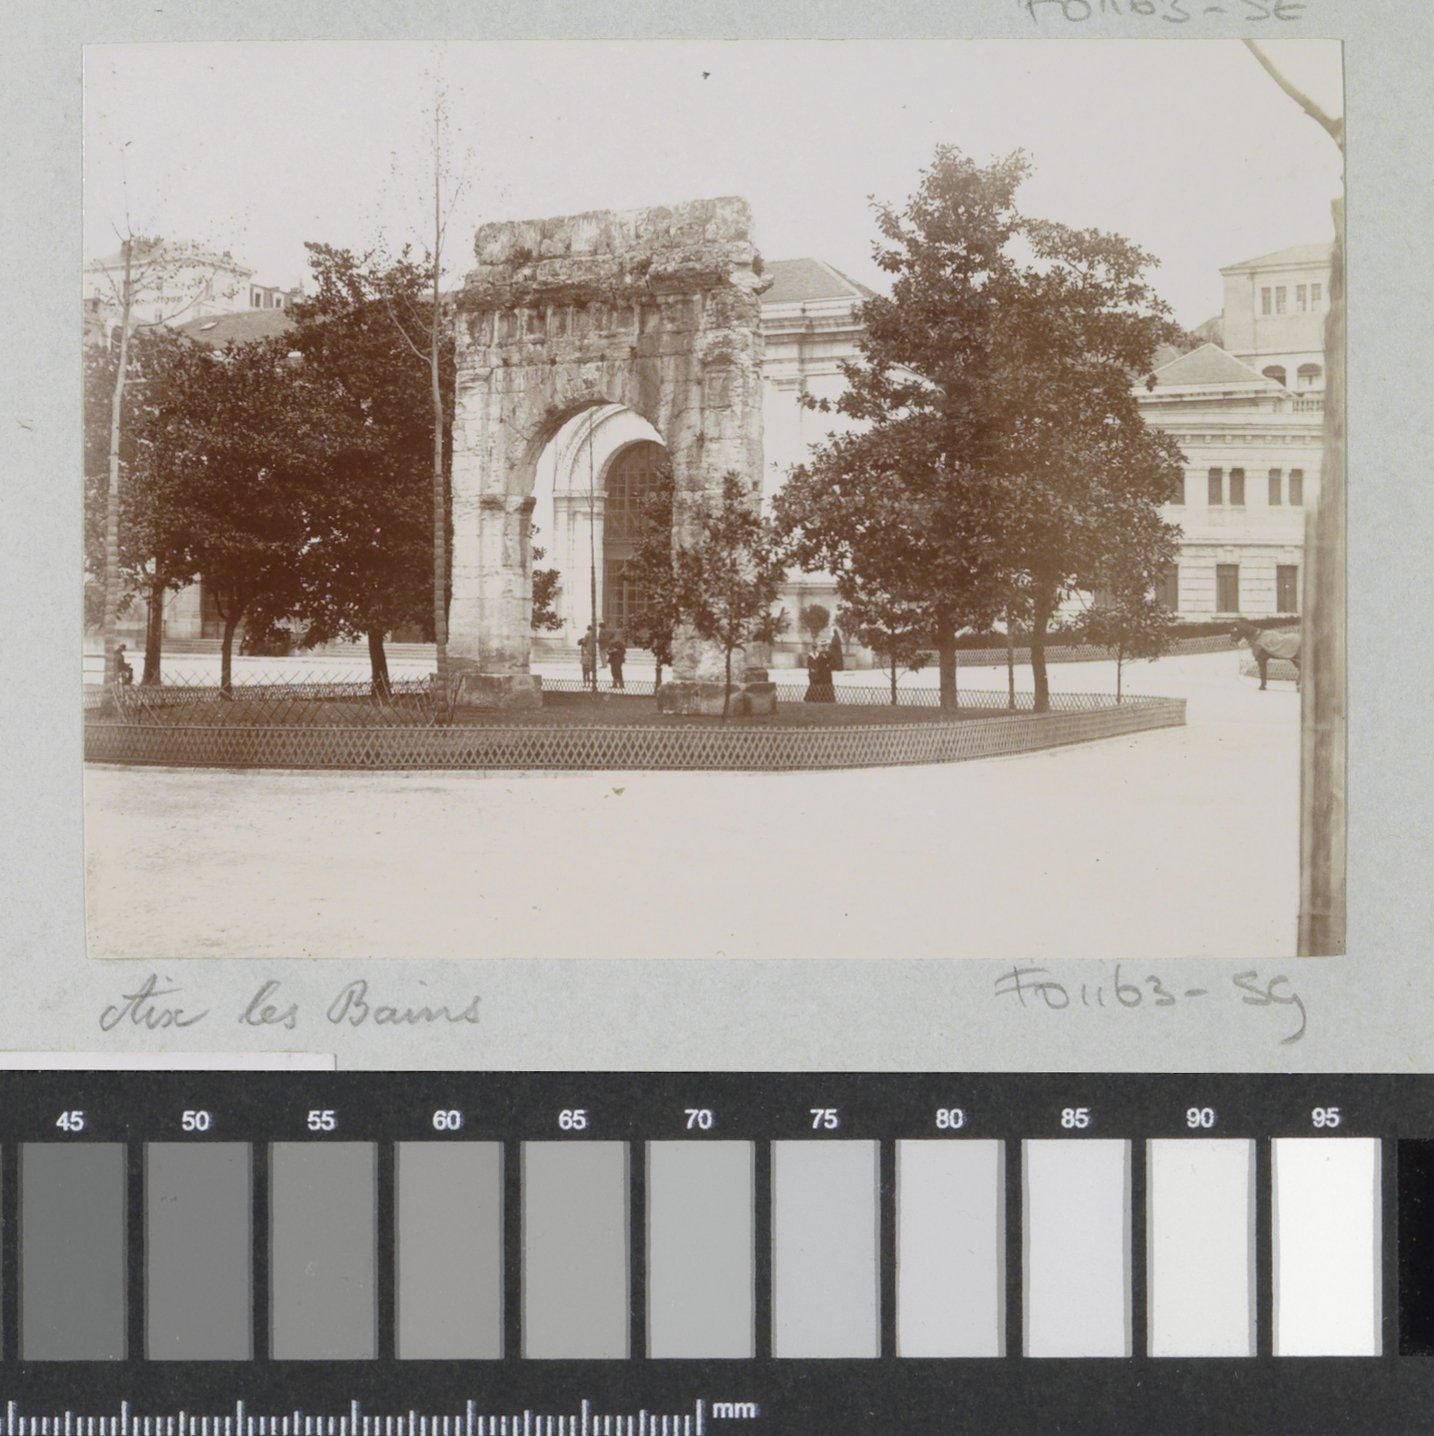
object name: photograph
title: Boog van Campanus in Aix-les-Bains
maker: delizy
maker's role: manufacturer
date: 1903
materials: paper, photographic support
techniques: gelatin silver print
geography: aix-les-bains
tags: arch, archivolt ~ architecture, grave-building, monumental tomb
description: Onderdeel van Fotoalbum van een Franse amateurfotograaf met opnames van uitstapjes in Frankrijk, Spanje, België, Luxemburg en Nederland, de eerste automobielen en autoraces.